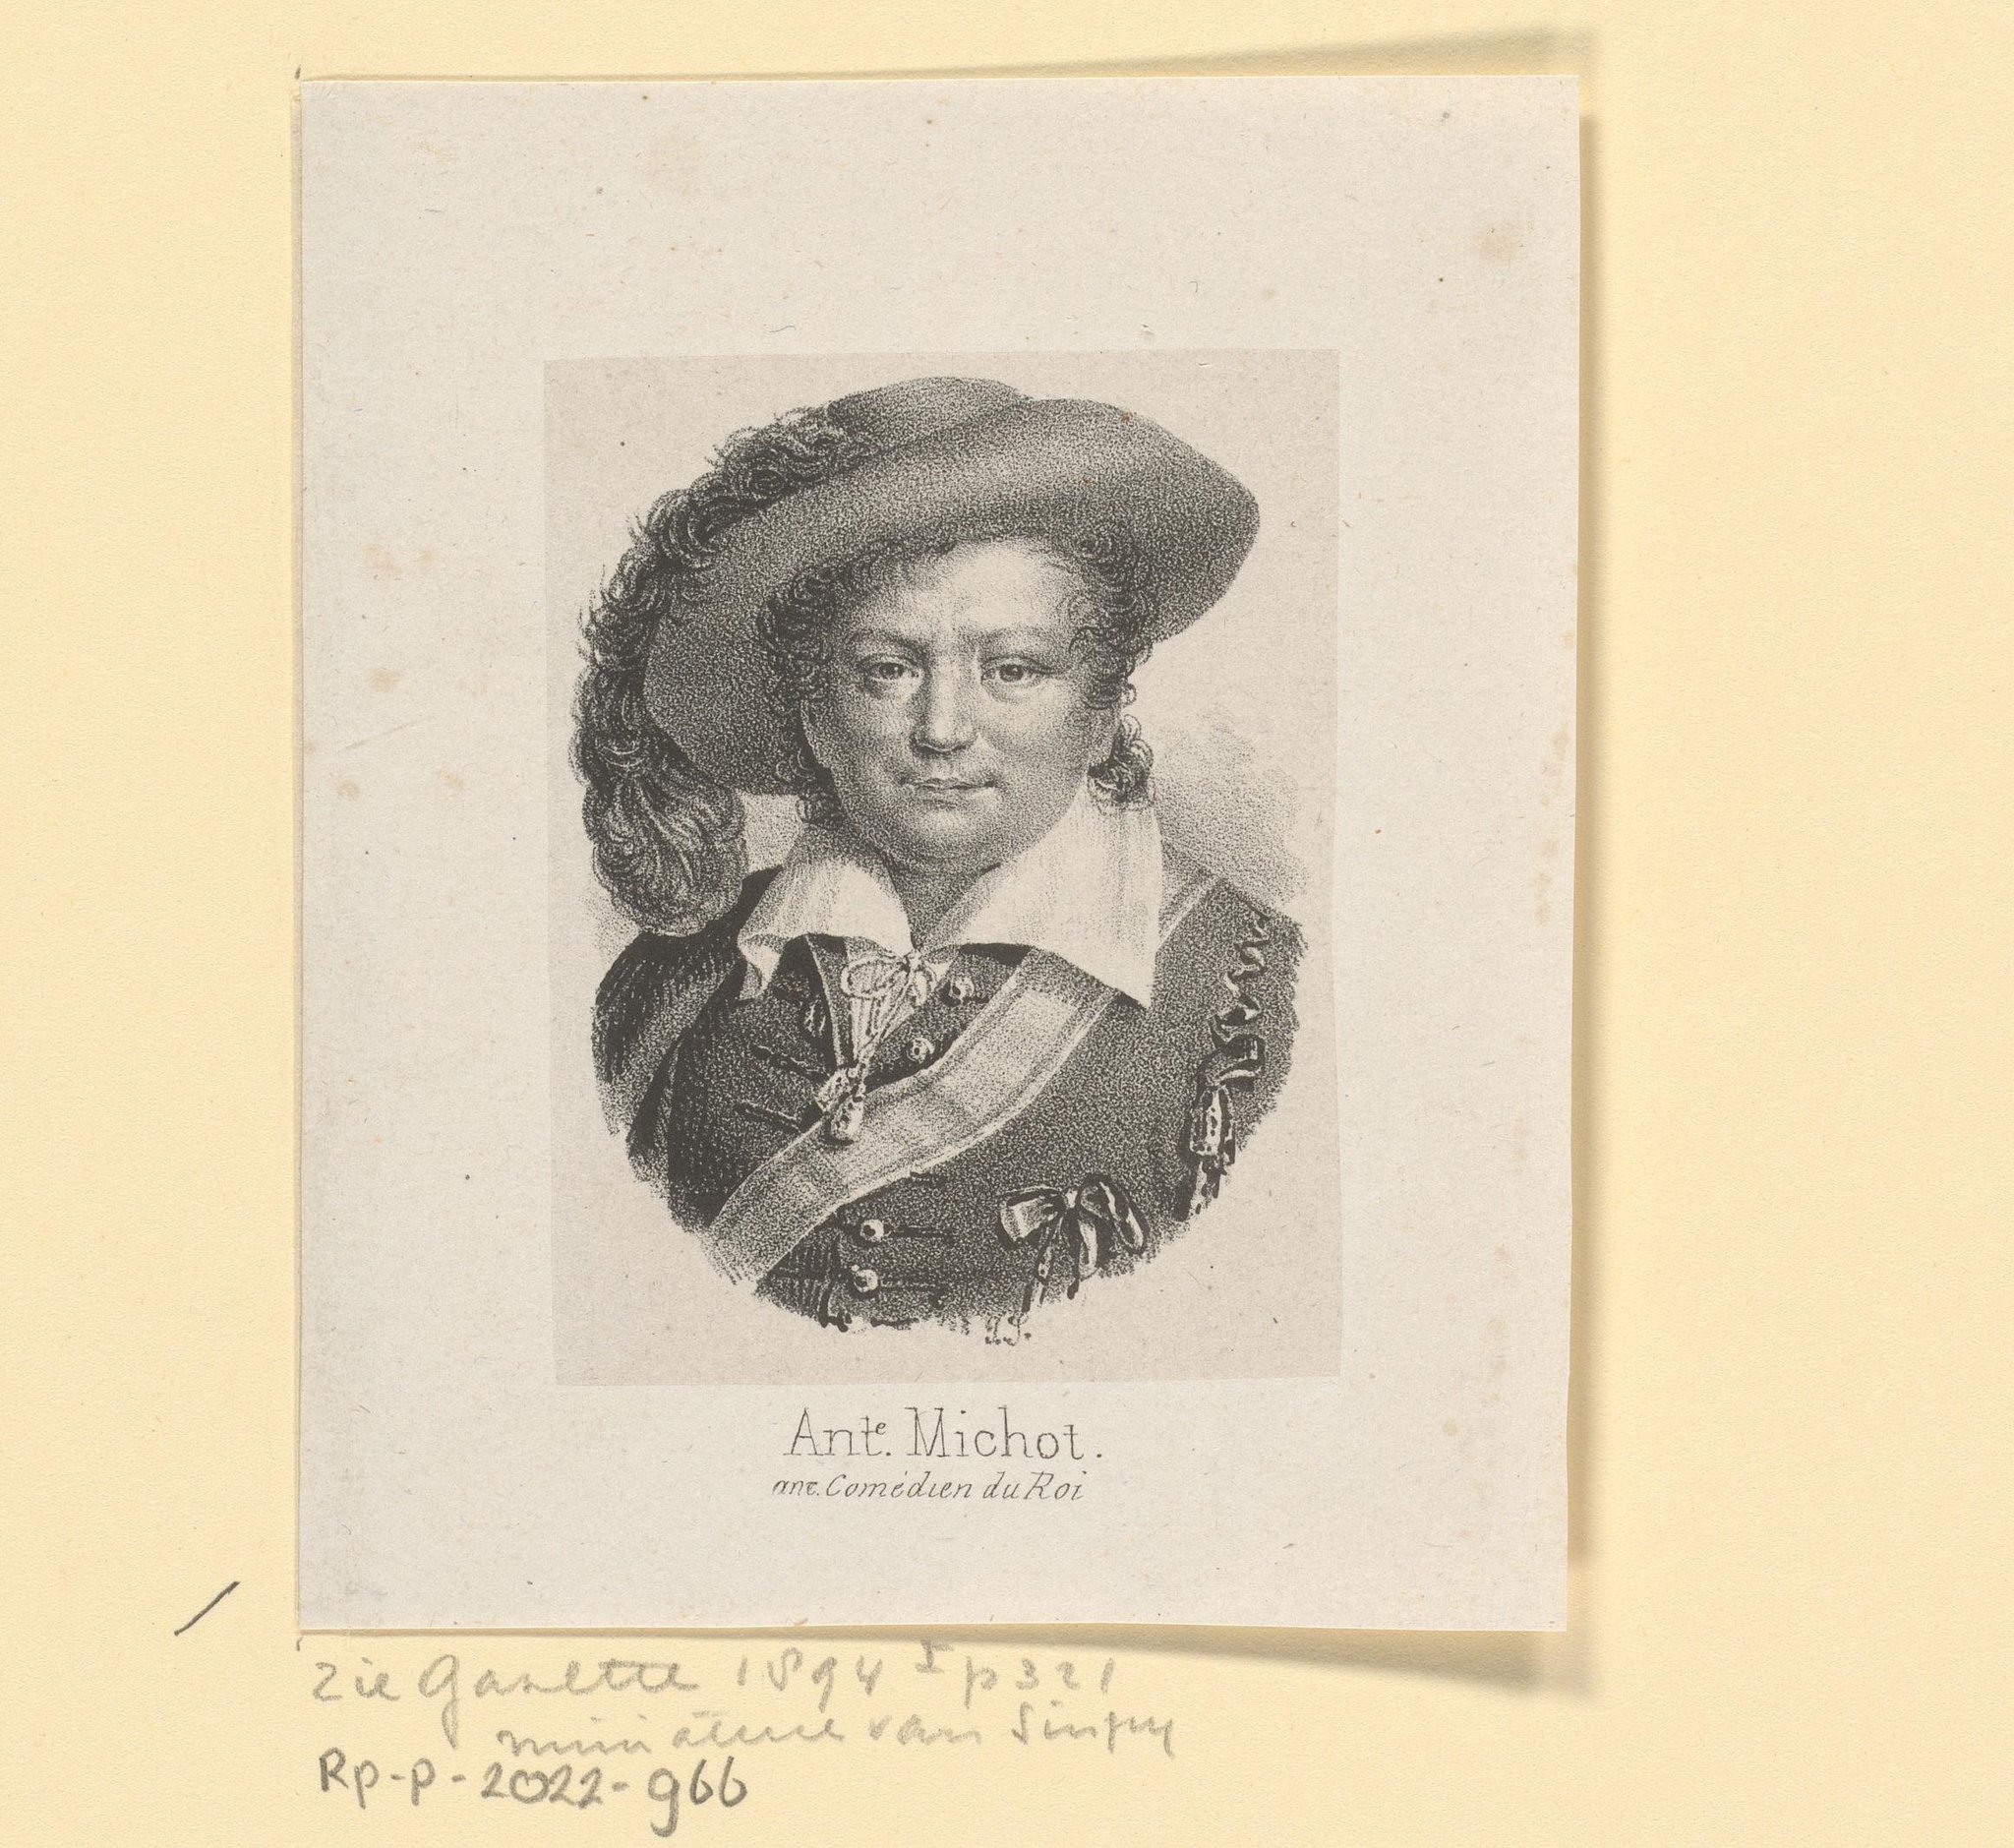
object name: print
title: Ante. Michot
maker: Anonymous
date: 1800-1850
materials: paper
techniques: lithograph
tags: portrait of artiste (dancer, actor, etc.), historical persons